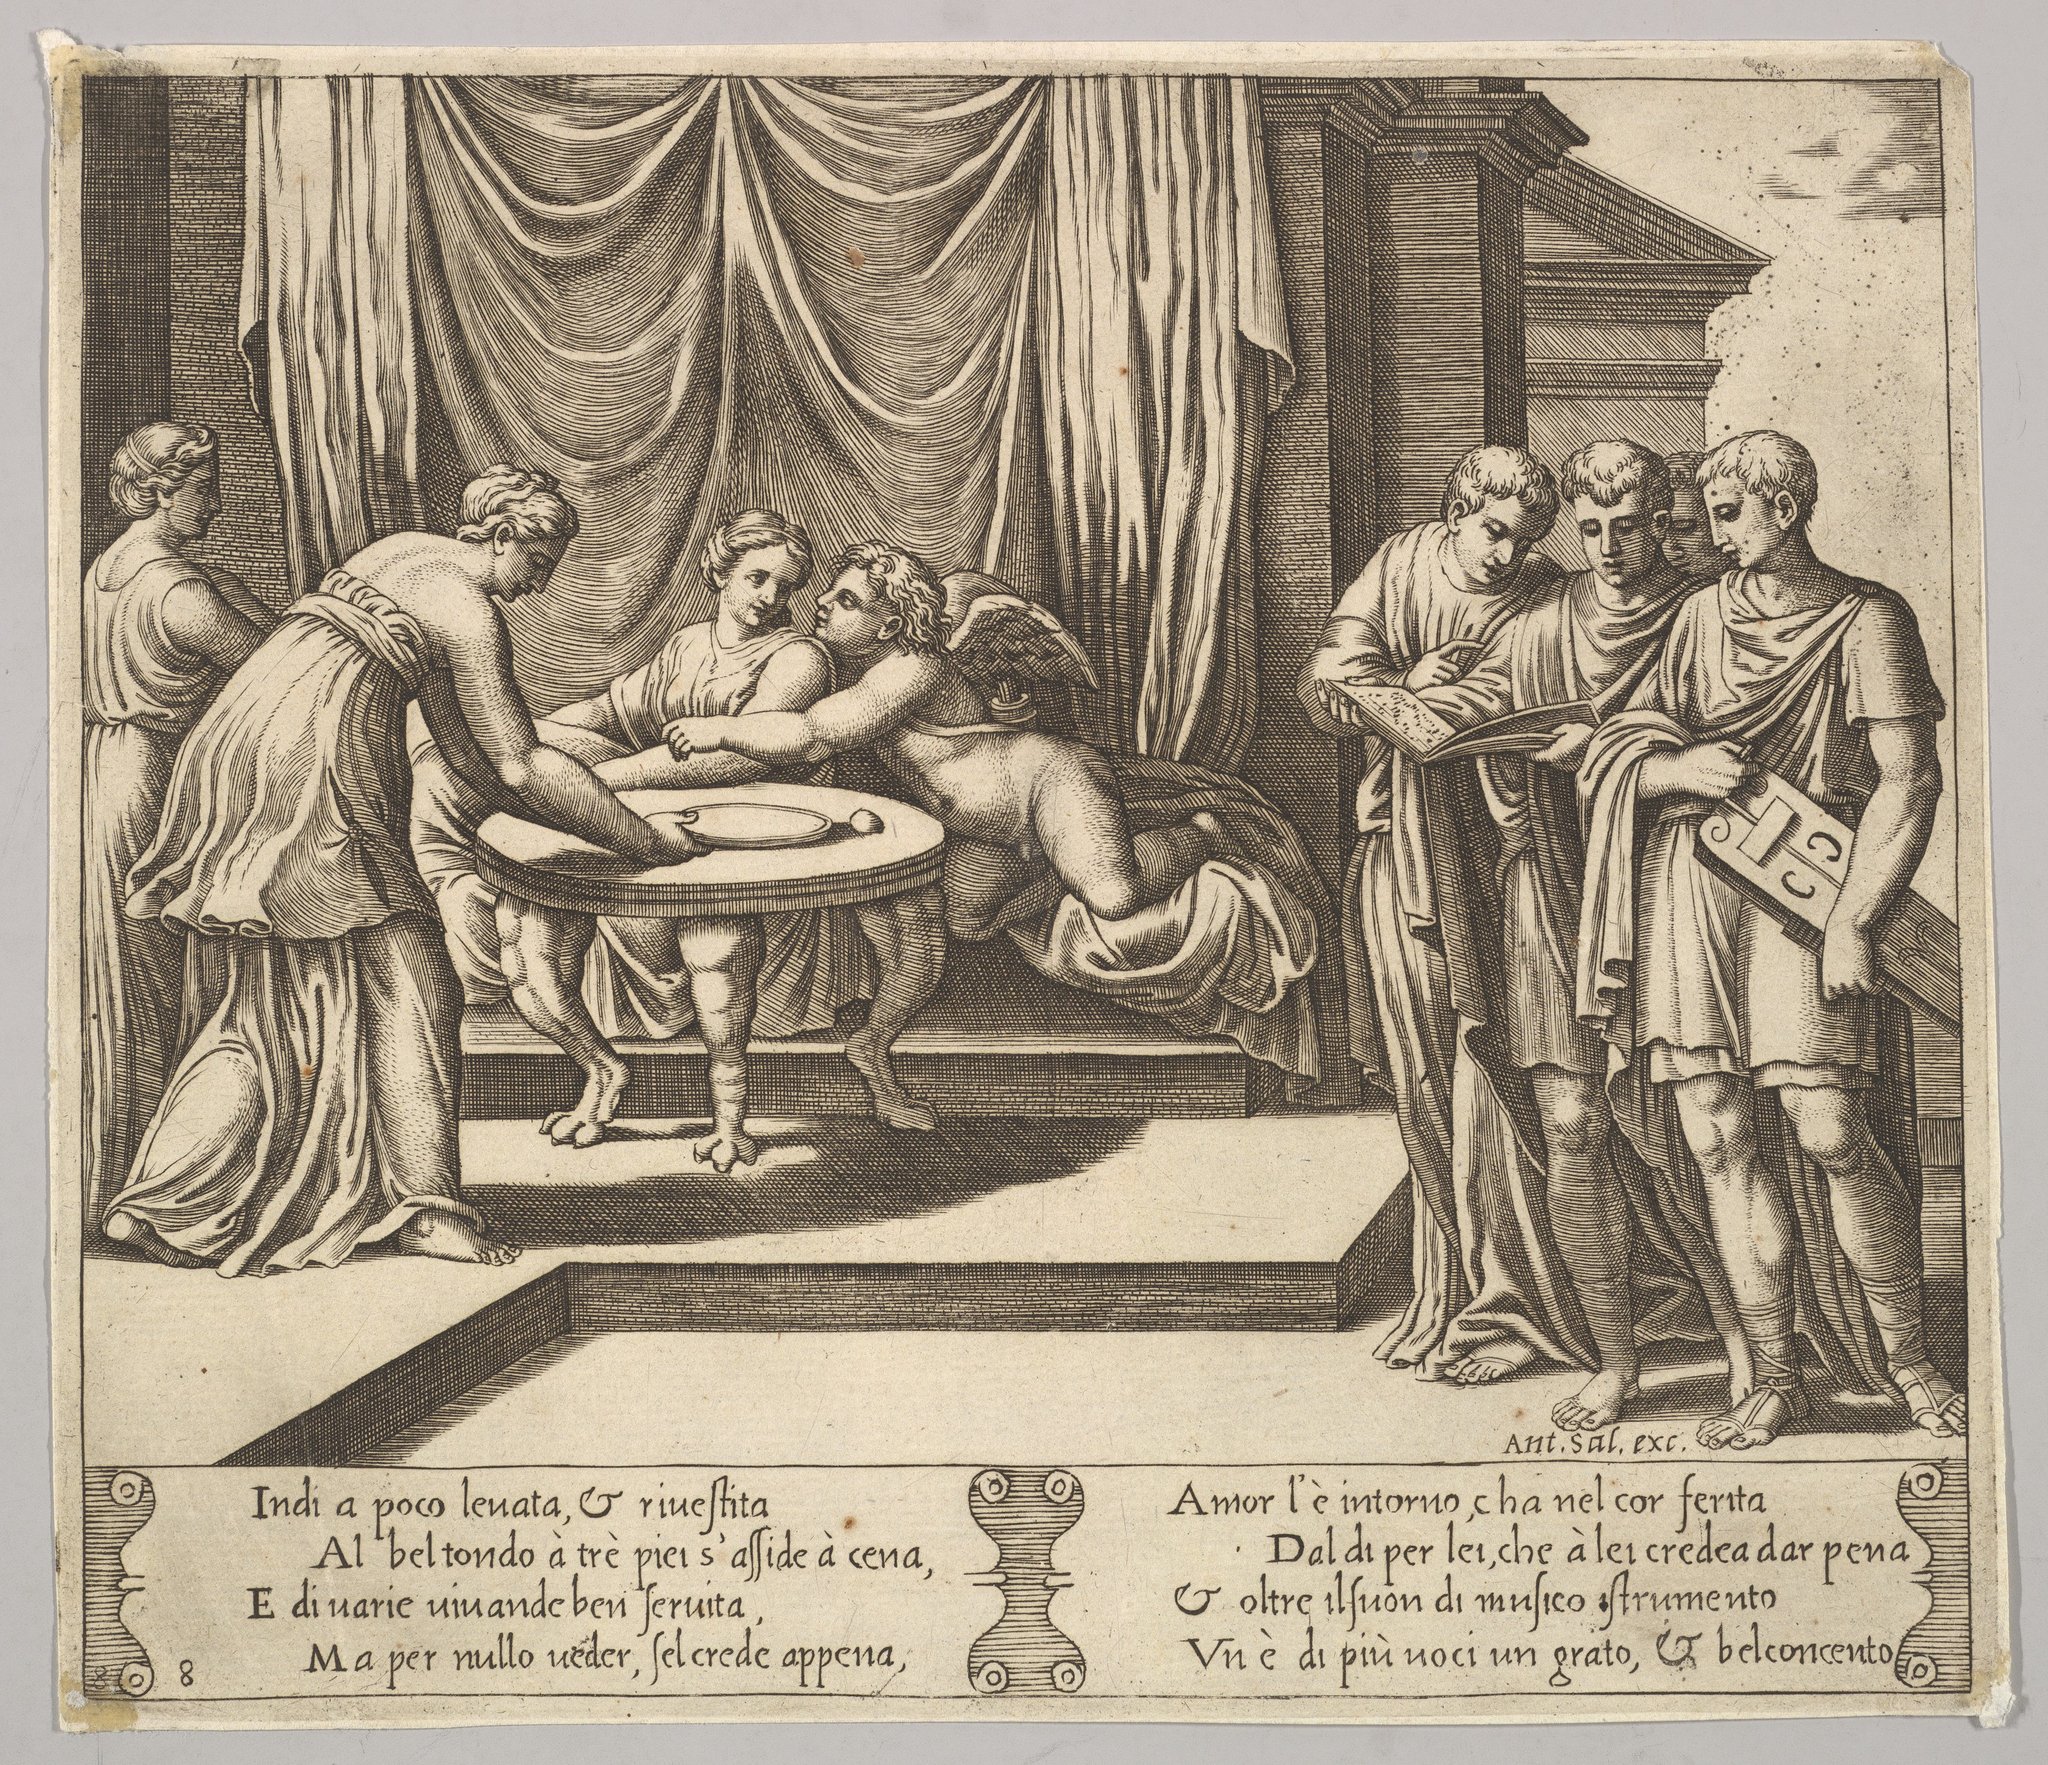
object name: print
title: Plate 8: Psyche seated at a table and attended by invisible servants, Eros beside the goddess, from "The Fable of Cupid and Psyche"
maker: master of the die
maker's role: artist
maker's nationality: italian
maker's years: 1525-1560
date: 1530-1560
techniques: engraving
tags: cupid,eros,psyche,goddess,servants